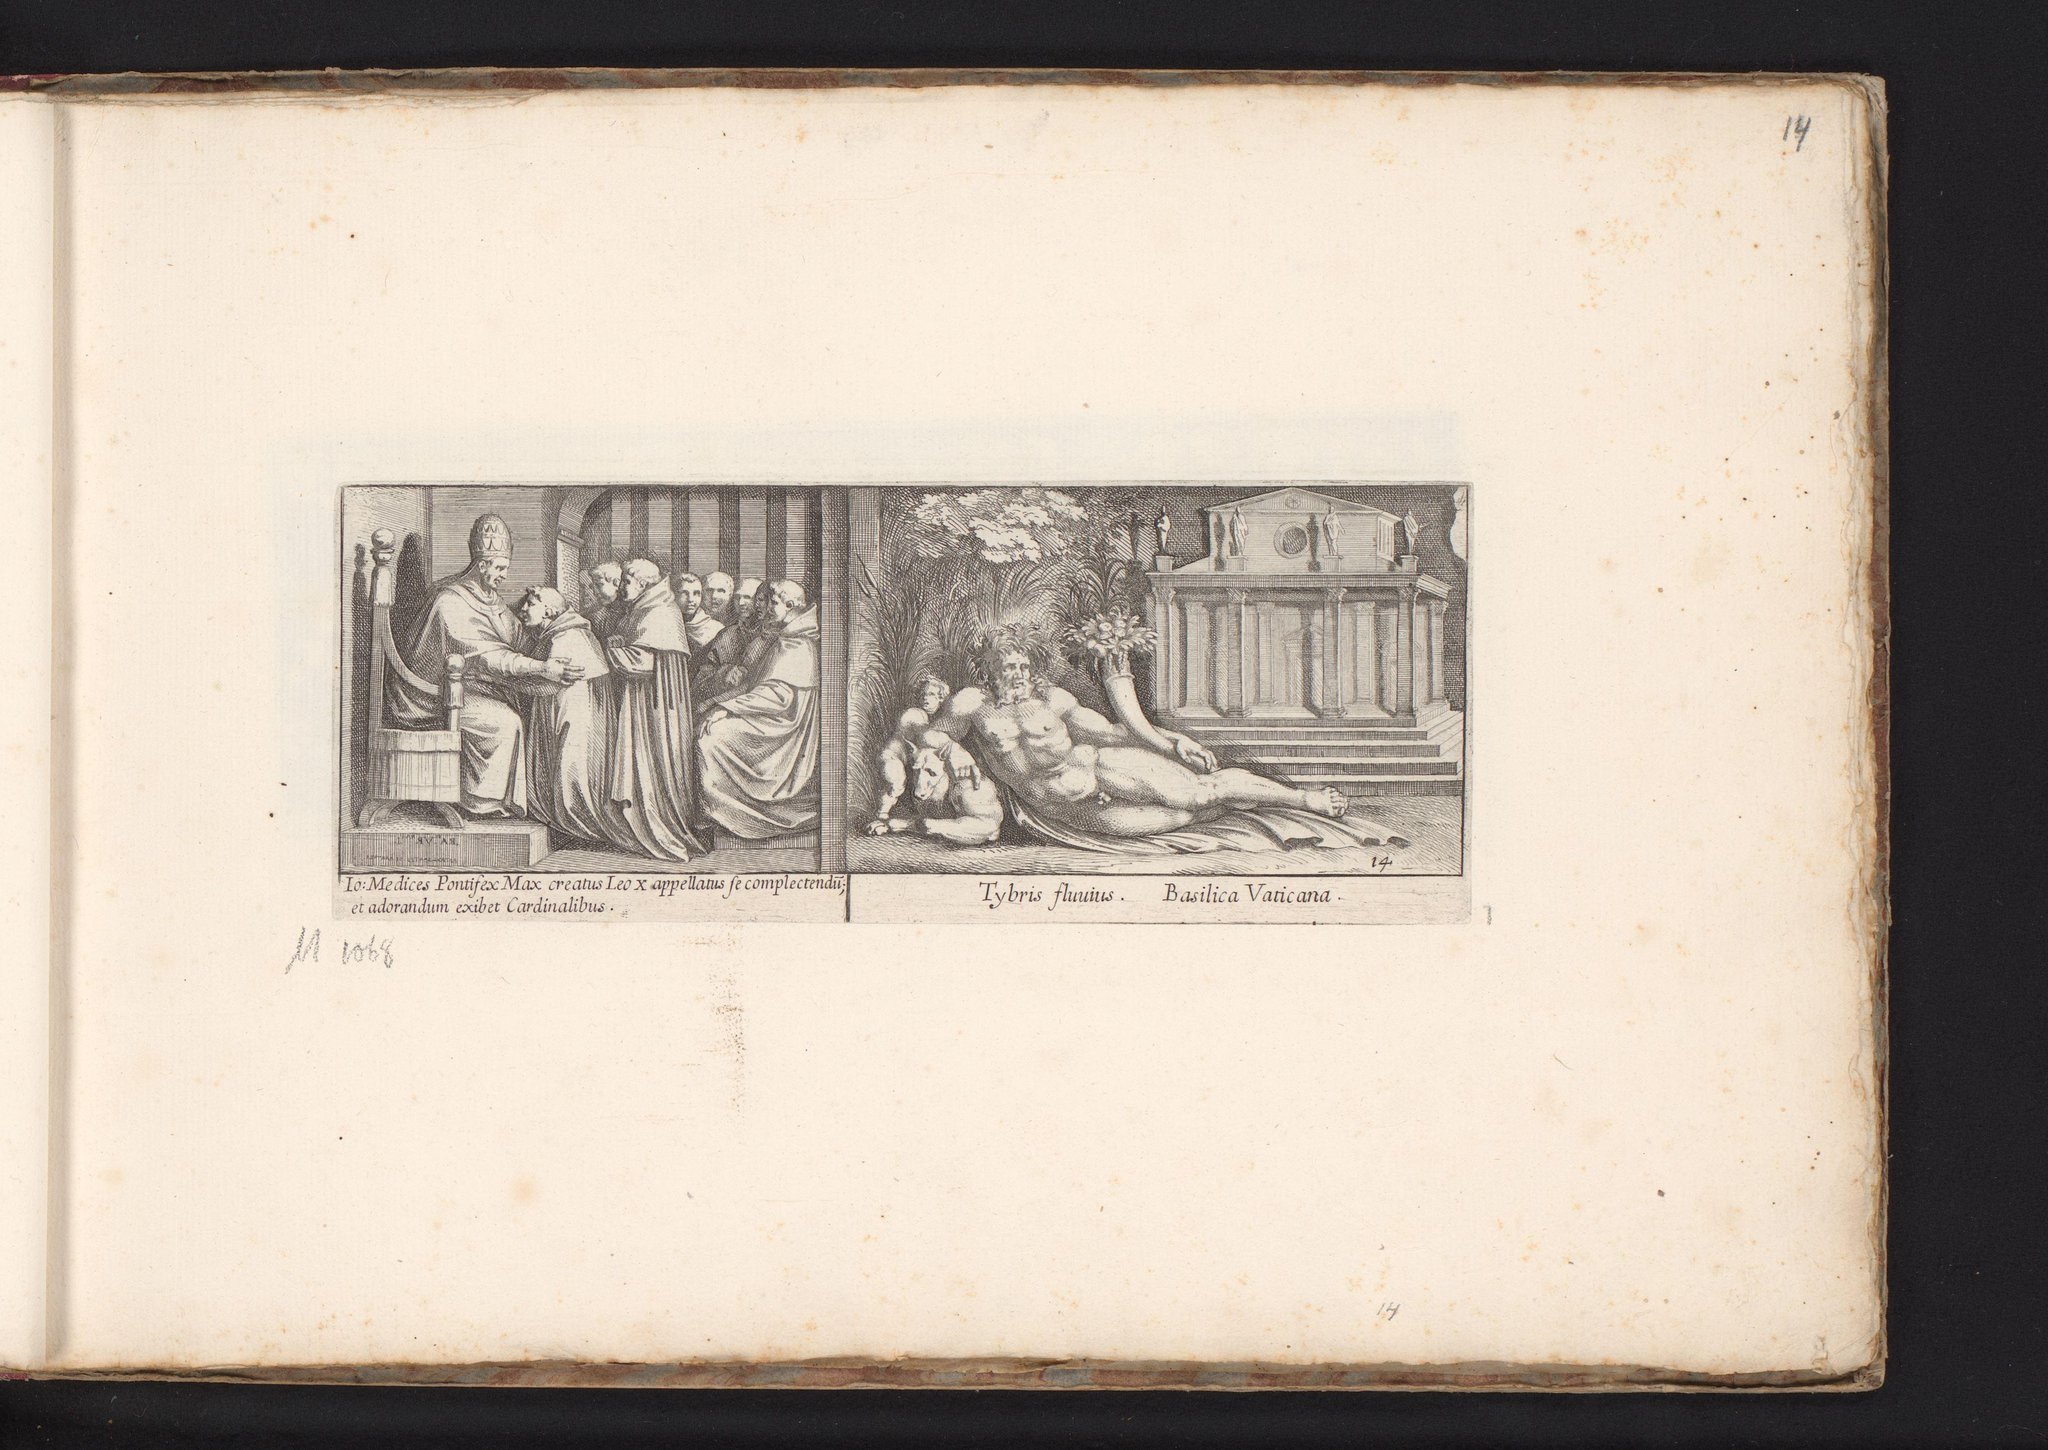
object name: album leaf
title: Giovanni de' Medici verkozen tot paus Leo X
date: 1645-1700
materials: paper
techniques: engraving, etching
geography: vatican city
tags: leo x, personification of river tiber; 'tevere' (ripa), cardinal, pope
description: Twee voorstellingen. Links: Giovanni de' Medici, verkozen tot paus Leo X, ontvangt het eerbetoon van de andere kardinalen. Rechts: een riviergod (de Tiber), een putto en een hond en op de achtergrond een basilica. Titel in ondermarge. Genummerd rechtsonder: 14. Prent maakt deel uit van een album